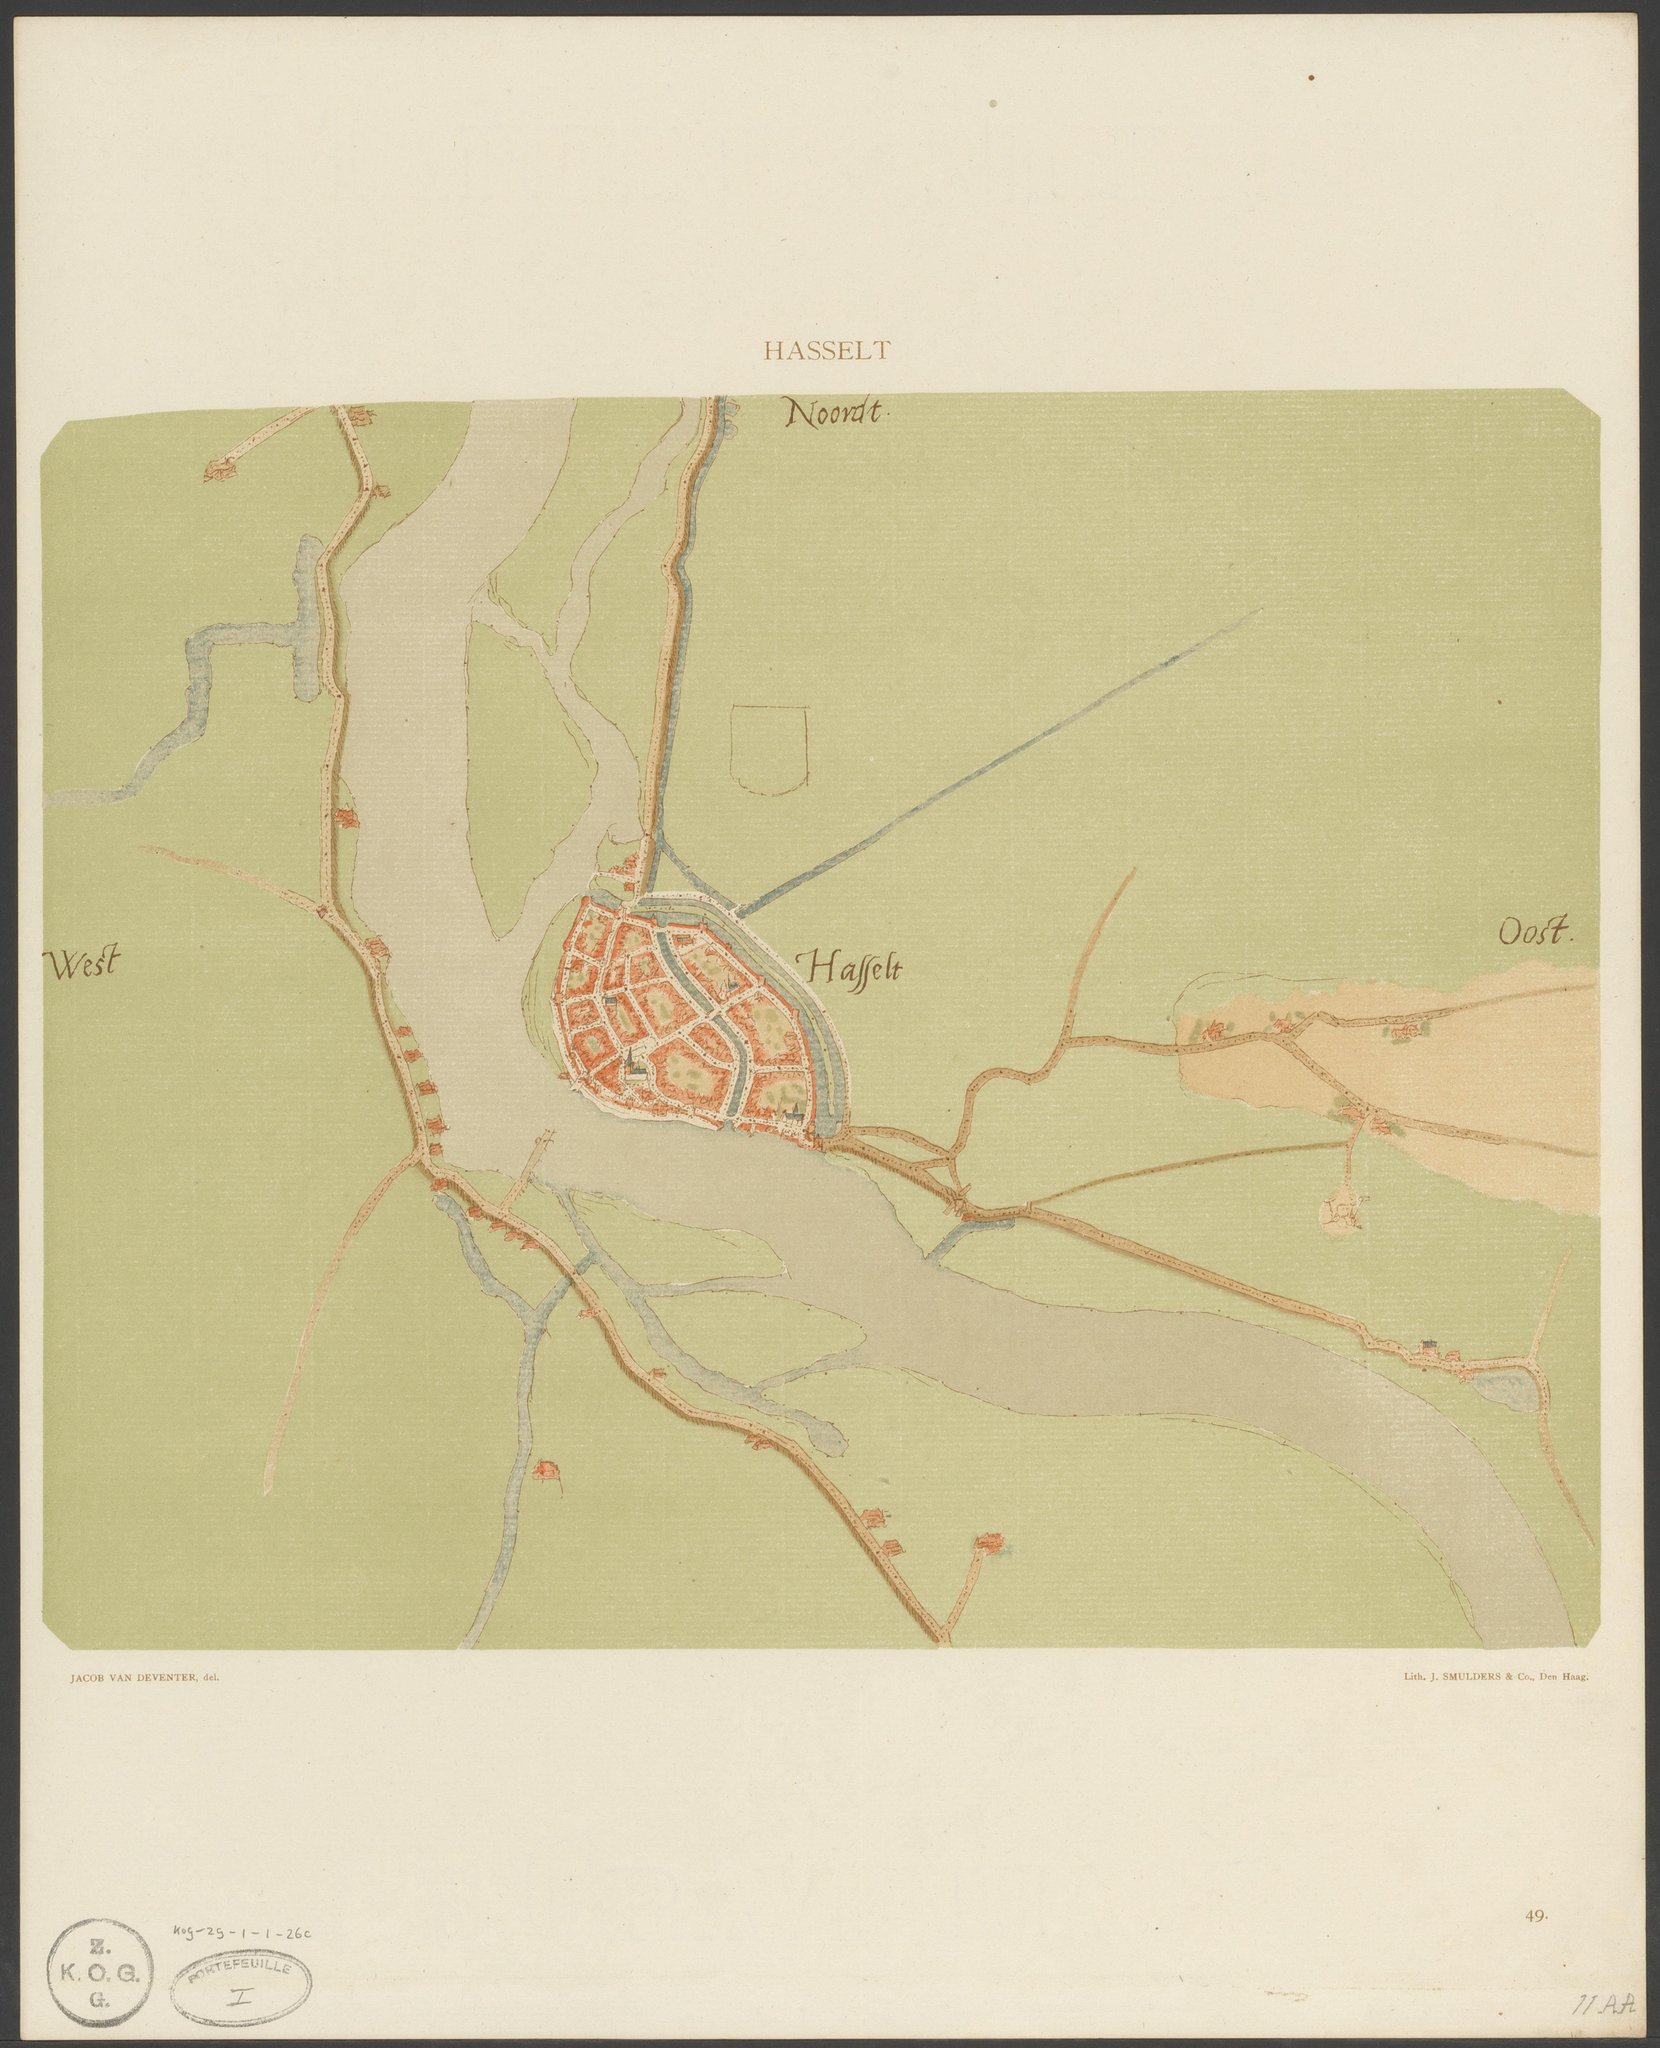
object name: area plan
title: Hasselt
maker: jacob van deventer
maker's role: draughtsman, print maker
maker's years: 1510-1575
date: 1916-1923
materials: paper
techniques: lithograph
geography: the hague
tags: maps of cities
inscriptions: collector's mark, collector's mark: Lugt 1641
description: Plattegrond van de stad Hasselt. Genummerd rechtsonder: 49. Onderdeel van een serie 'Nederlandsche Steden in de 16e eeuw', reproducties naar de oorspronkelijke topografische tekeningen van Jacob van Deventer. Onderwerpsrubrieken binnen de Atlas Zeden en Gewoonten: topografie; stadsplattegronden.